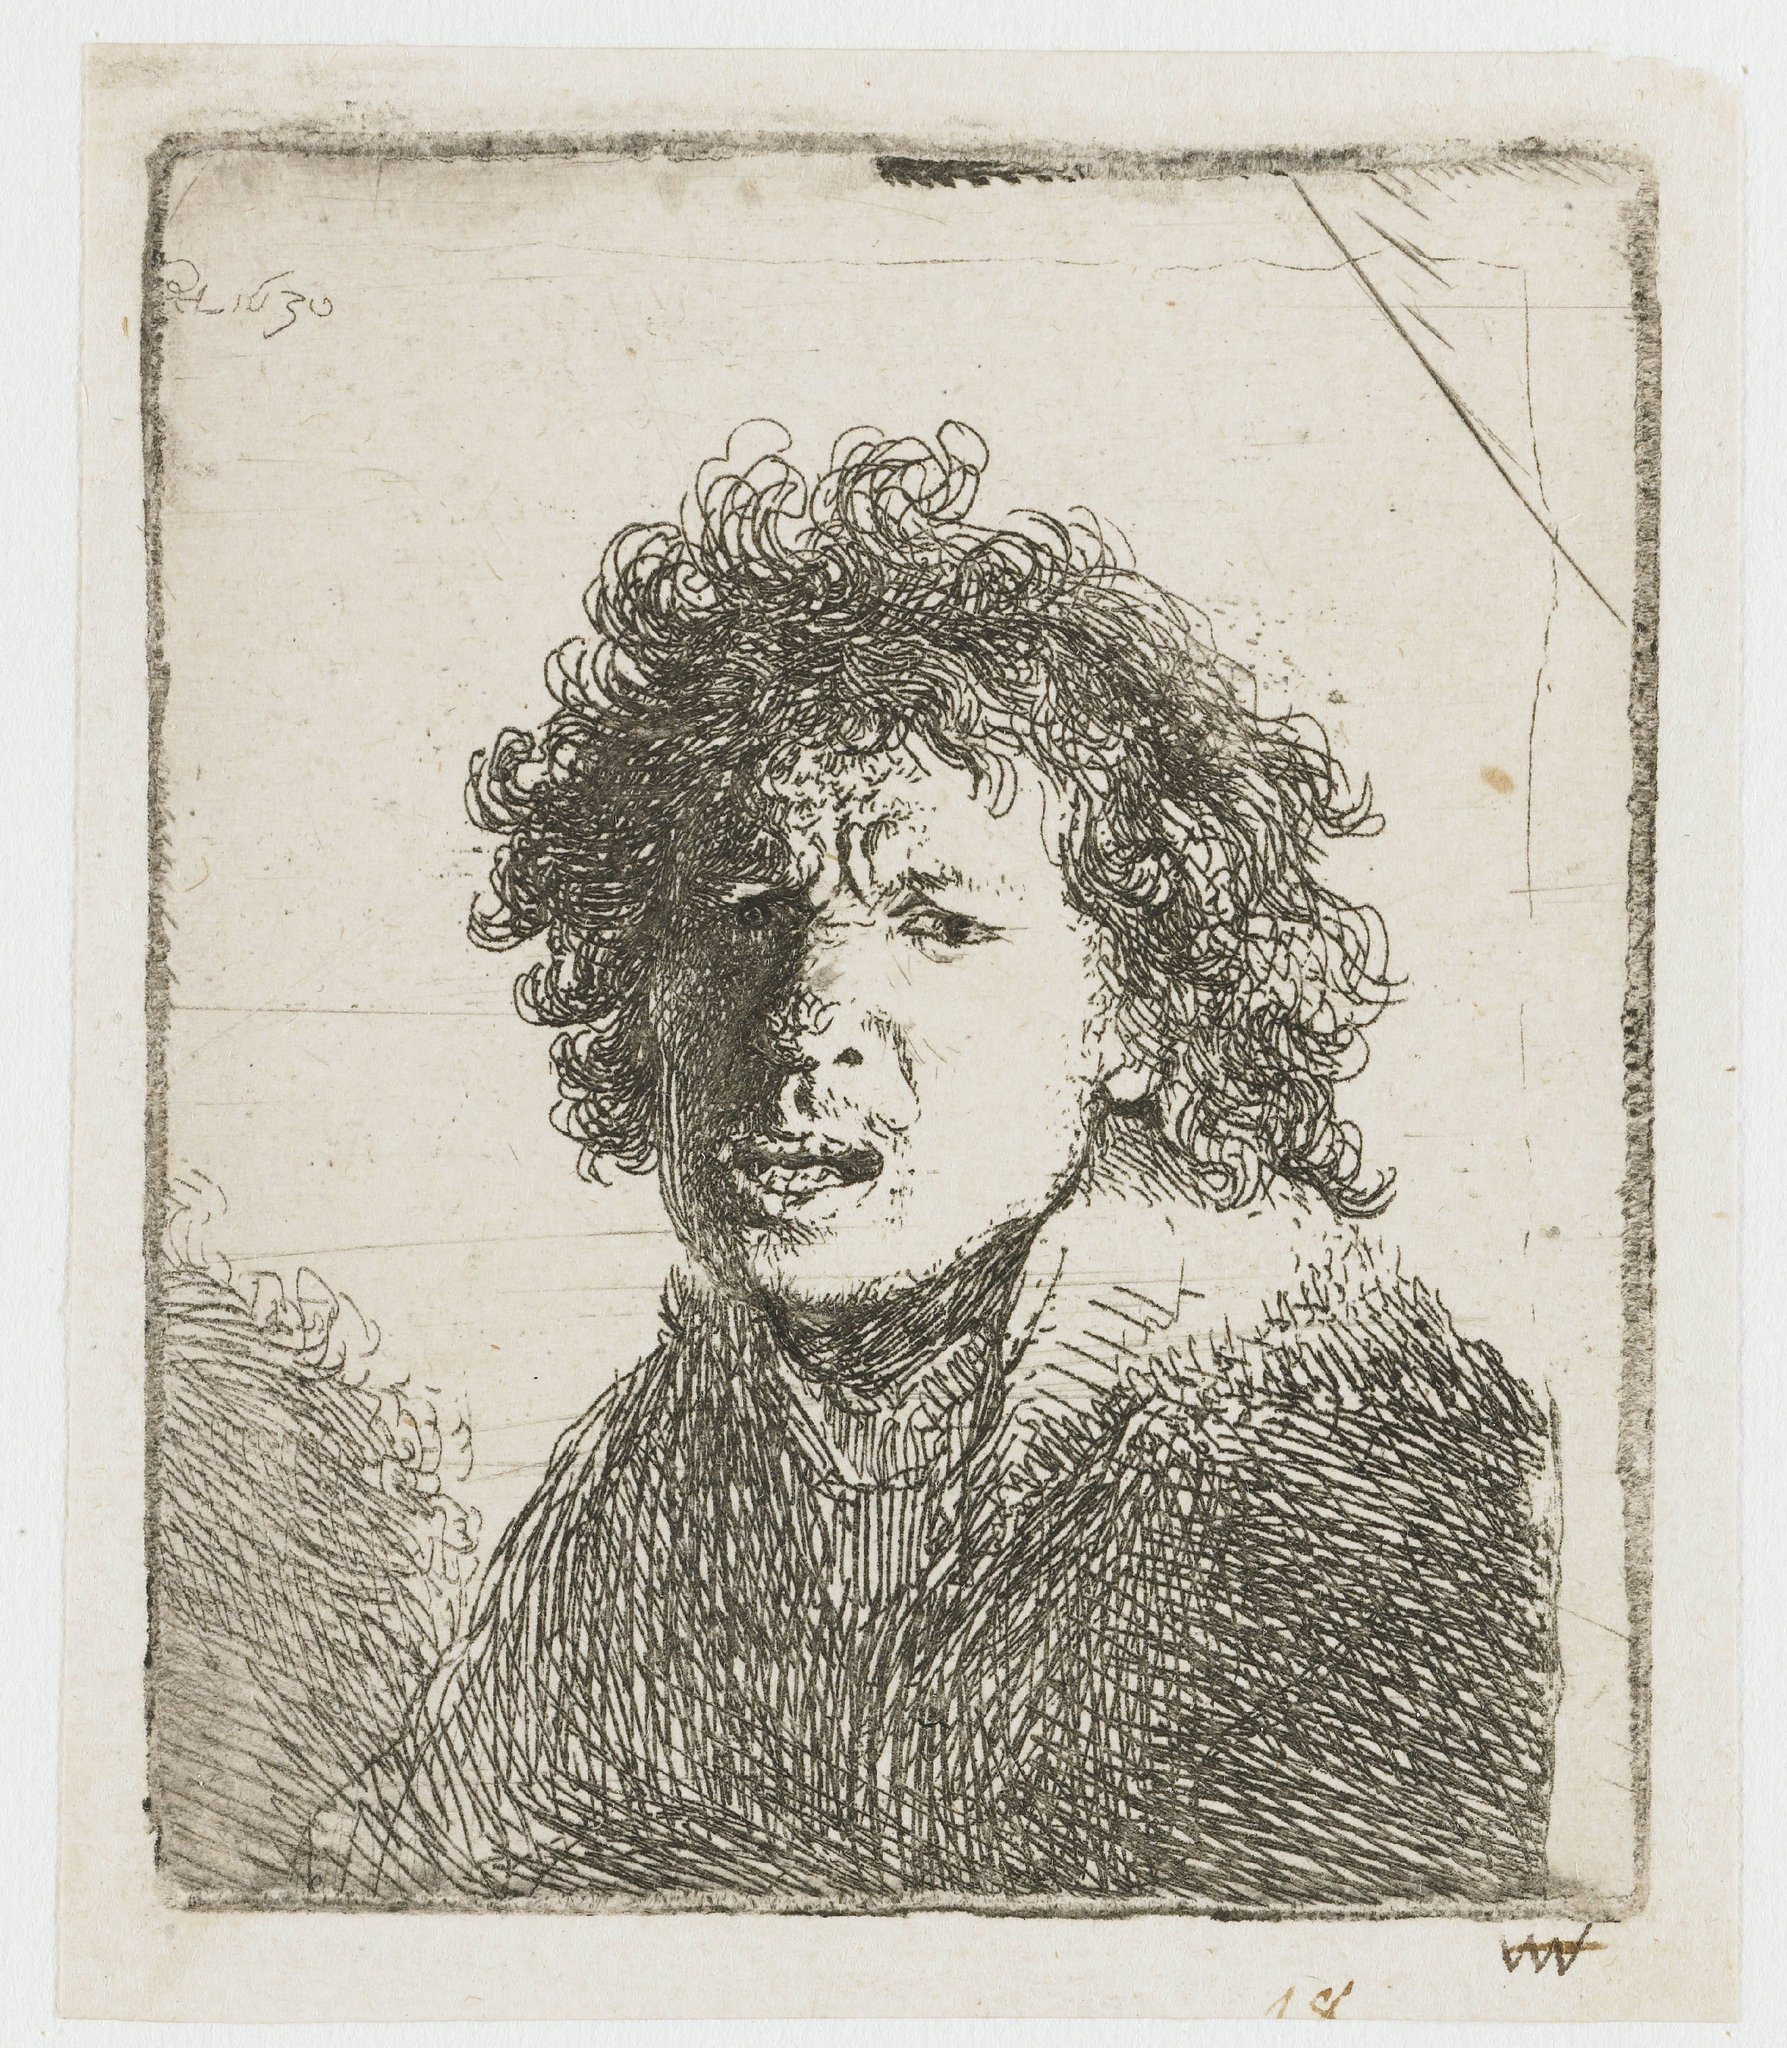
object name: print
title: Self-portrait open mouthed, as if shouting: bust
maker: rembrandt van rijn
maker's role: draughtsman, painter, print maker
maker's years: 1606-1669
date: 1630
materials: paper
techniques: etching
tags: leiden, amsterdam, painter, print maker, draughtsman, rembrandt van rijn, portrait, self-portrait of graphic artist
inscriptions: collector's mark: Lugt 2228, number: ‘18’, inscription: ‘VW met horizontale streep erdoor’, monogram and date: ‘RHL 1630’